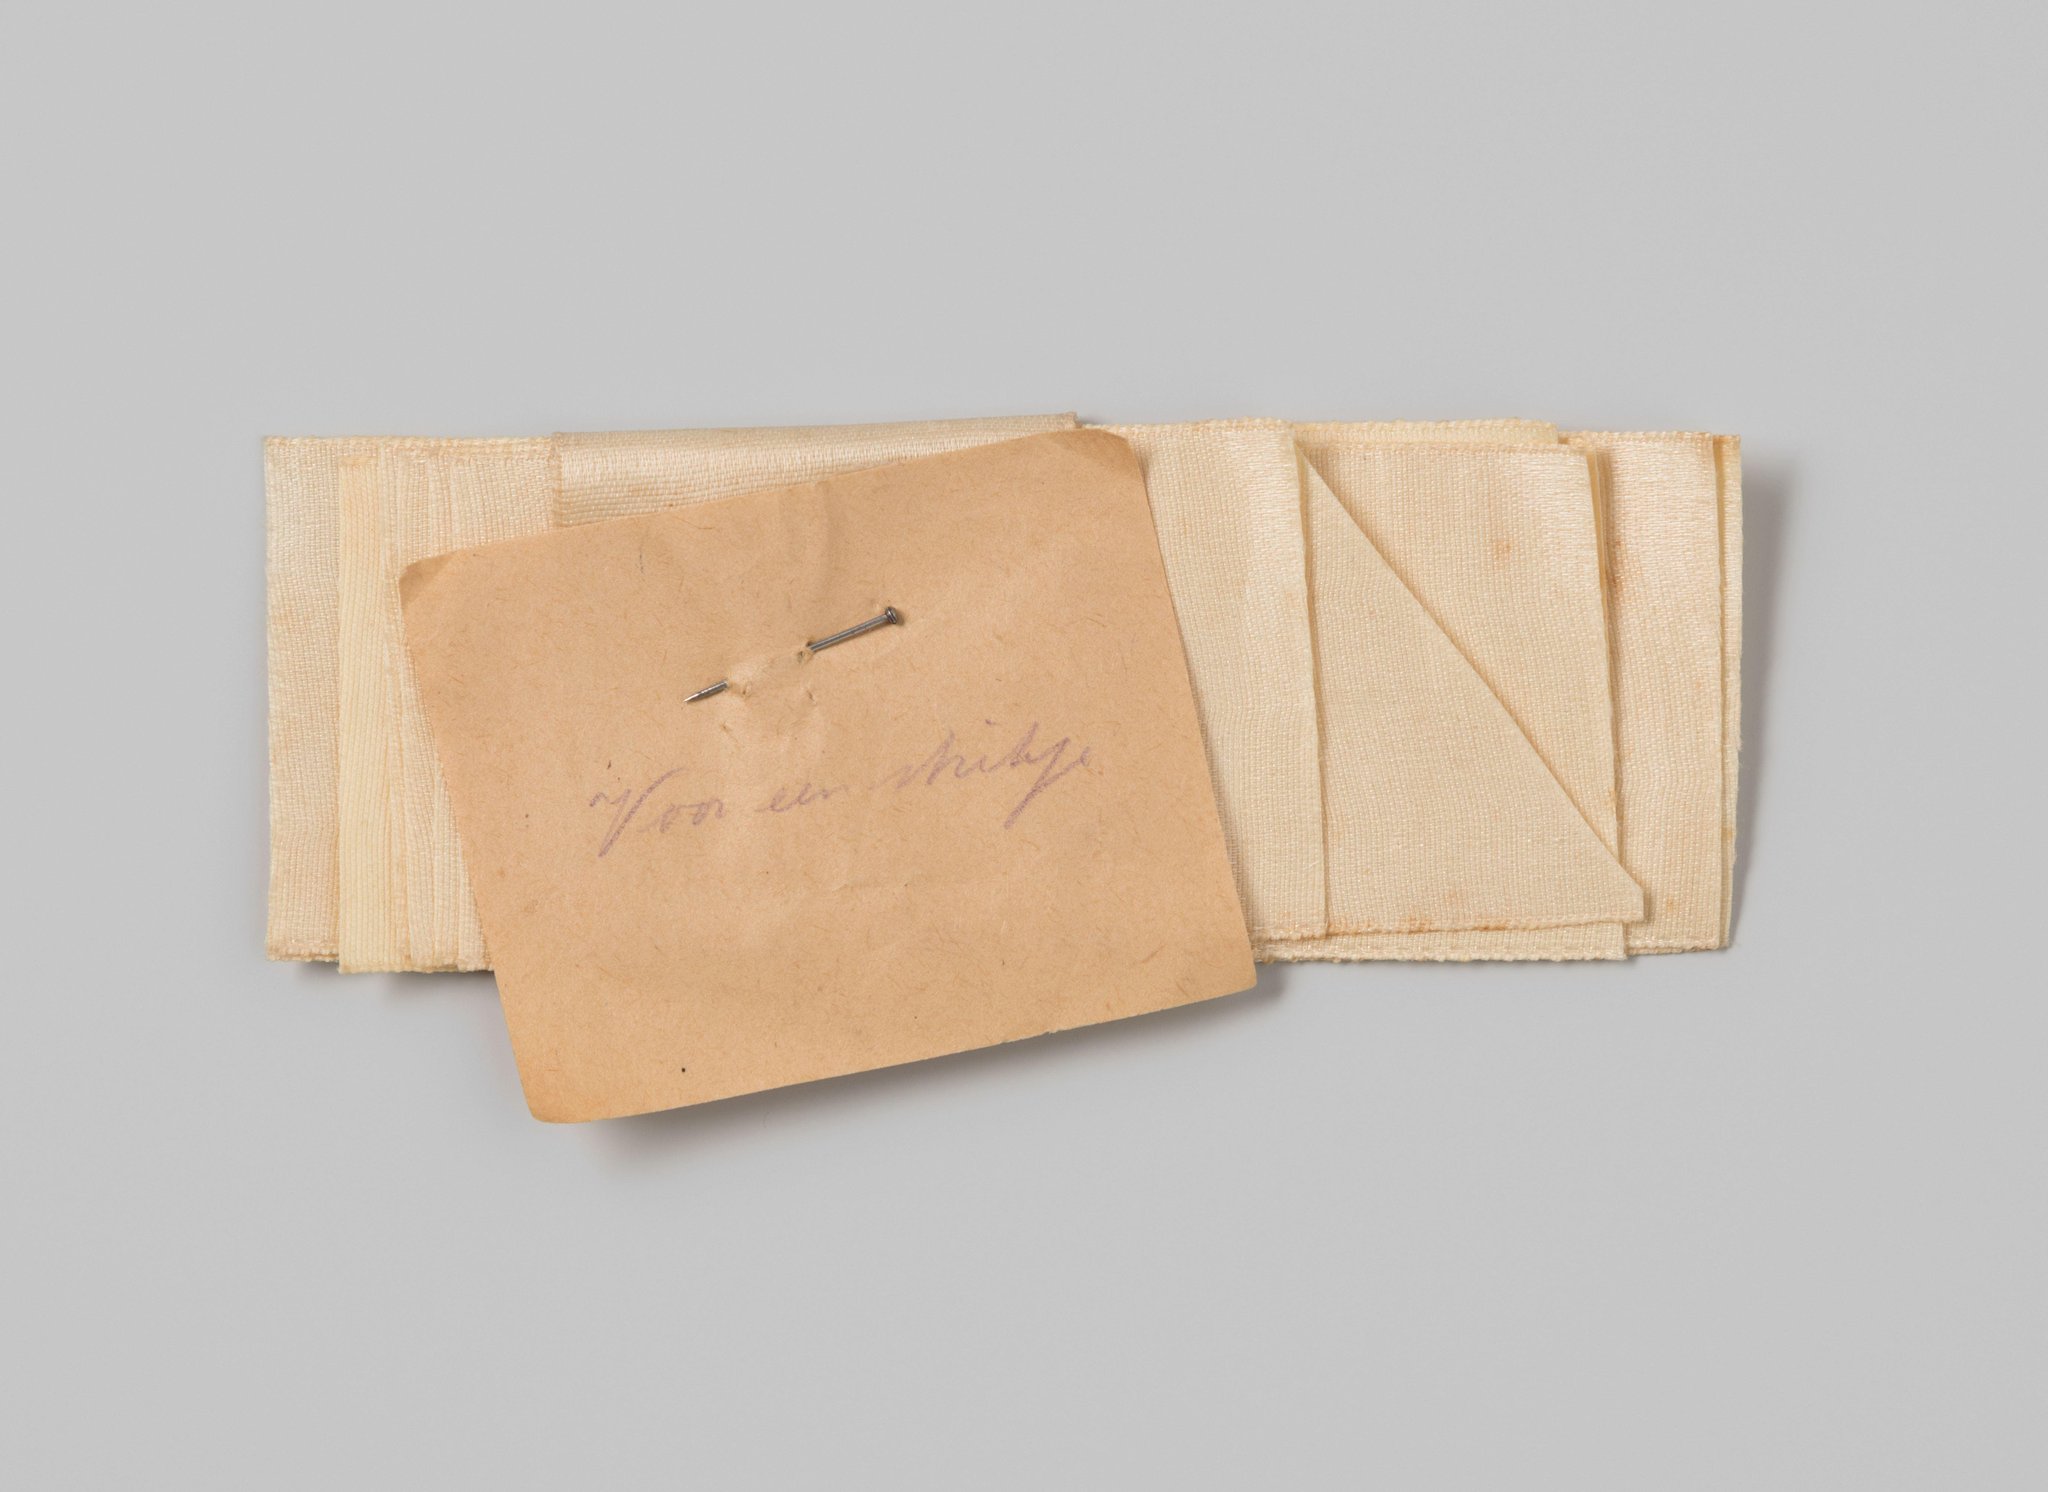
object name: braid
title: Crème zijden satijnlint voor een strik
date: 1925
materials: silk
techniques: satin binding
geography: france